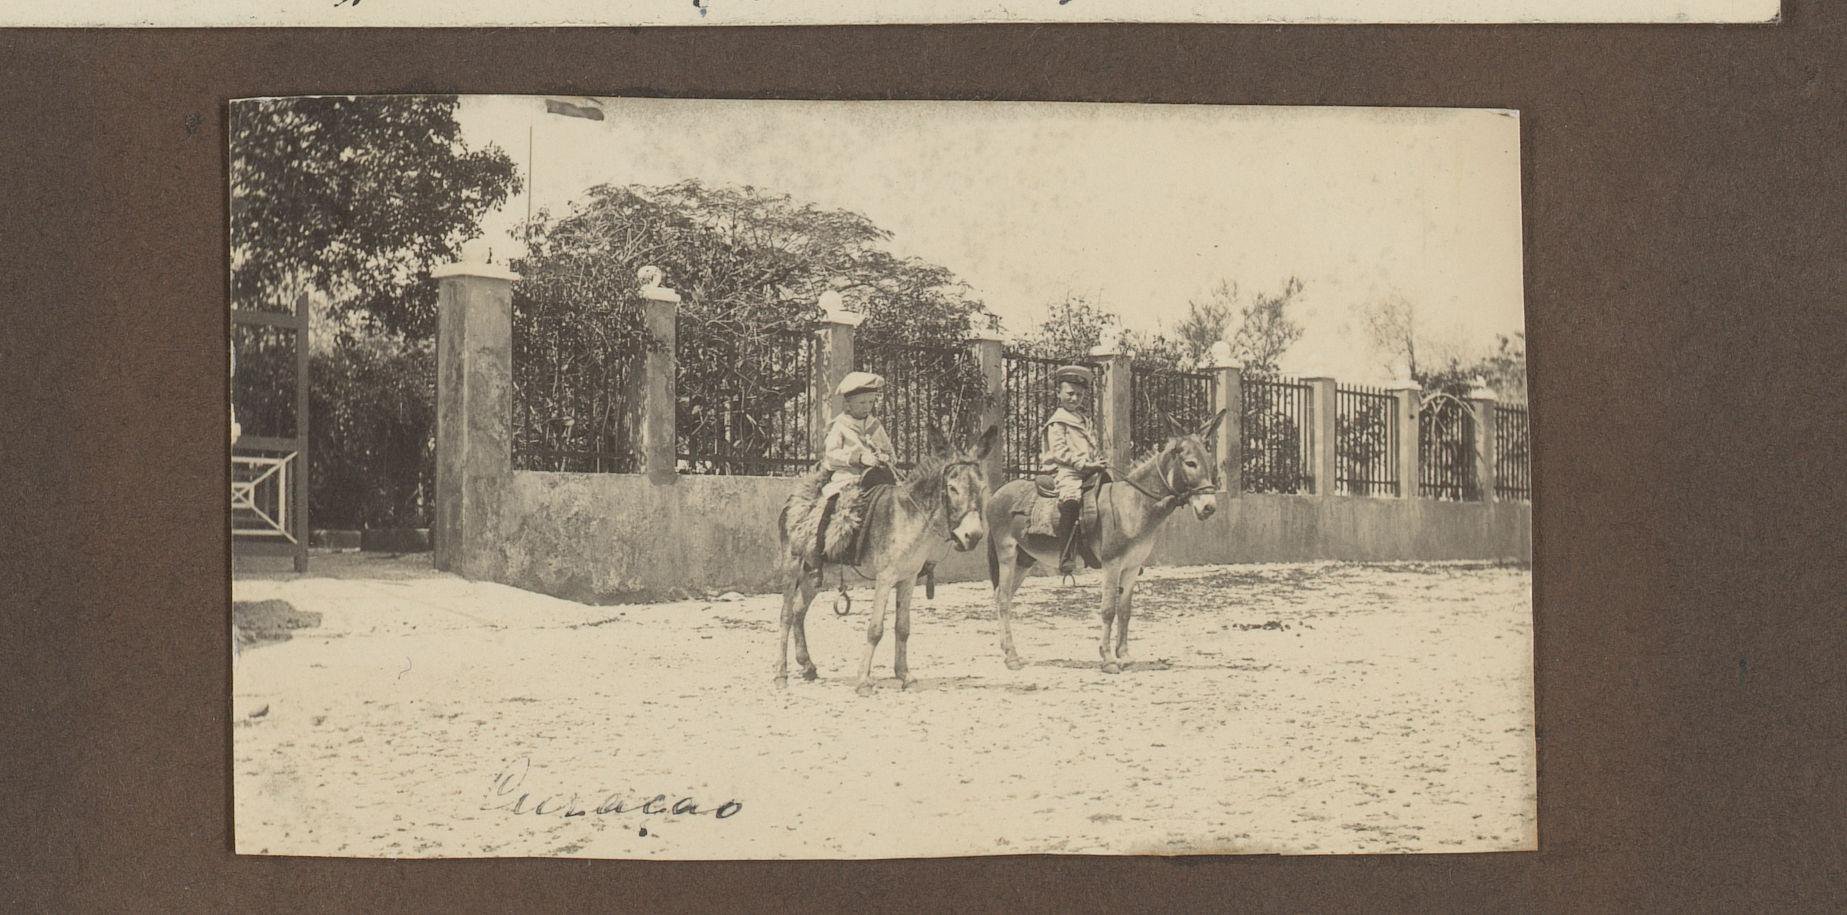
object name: photograph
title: Twee jongens in matrozenpakken op ezels in Curaçao, vermoedelijk de kinderen van Jan Olphert de Jong van Beek en Donk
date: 1895-1925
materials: paper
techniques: gelatin silver print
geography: curacao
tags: ass, donkey, boy (child between toddler and youth), historical persons not known by name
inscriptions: inscription: ‘Curaçao’